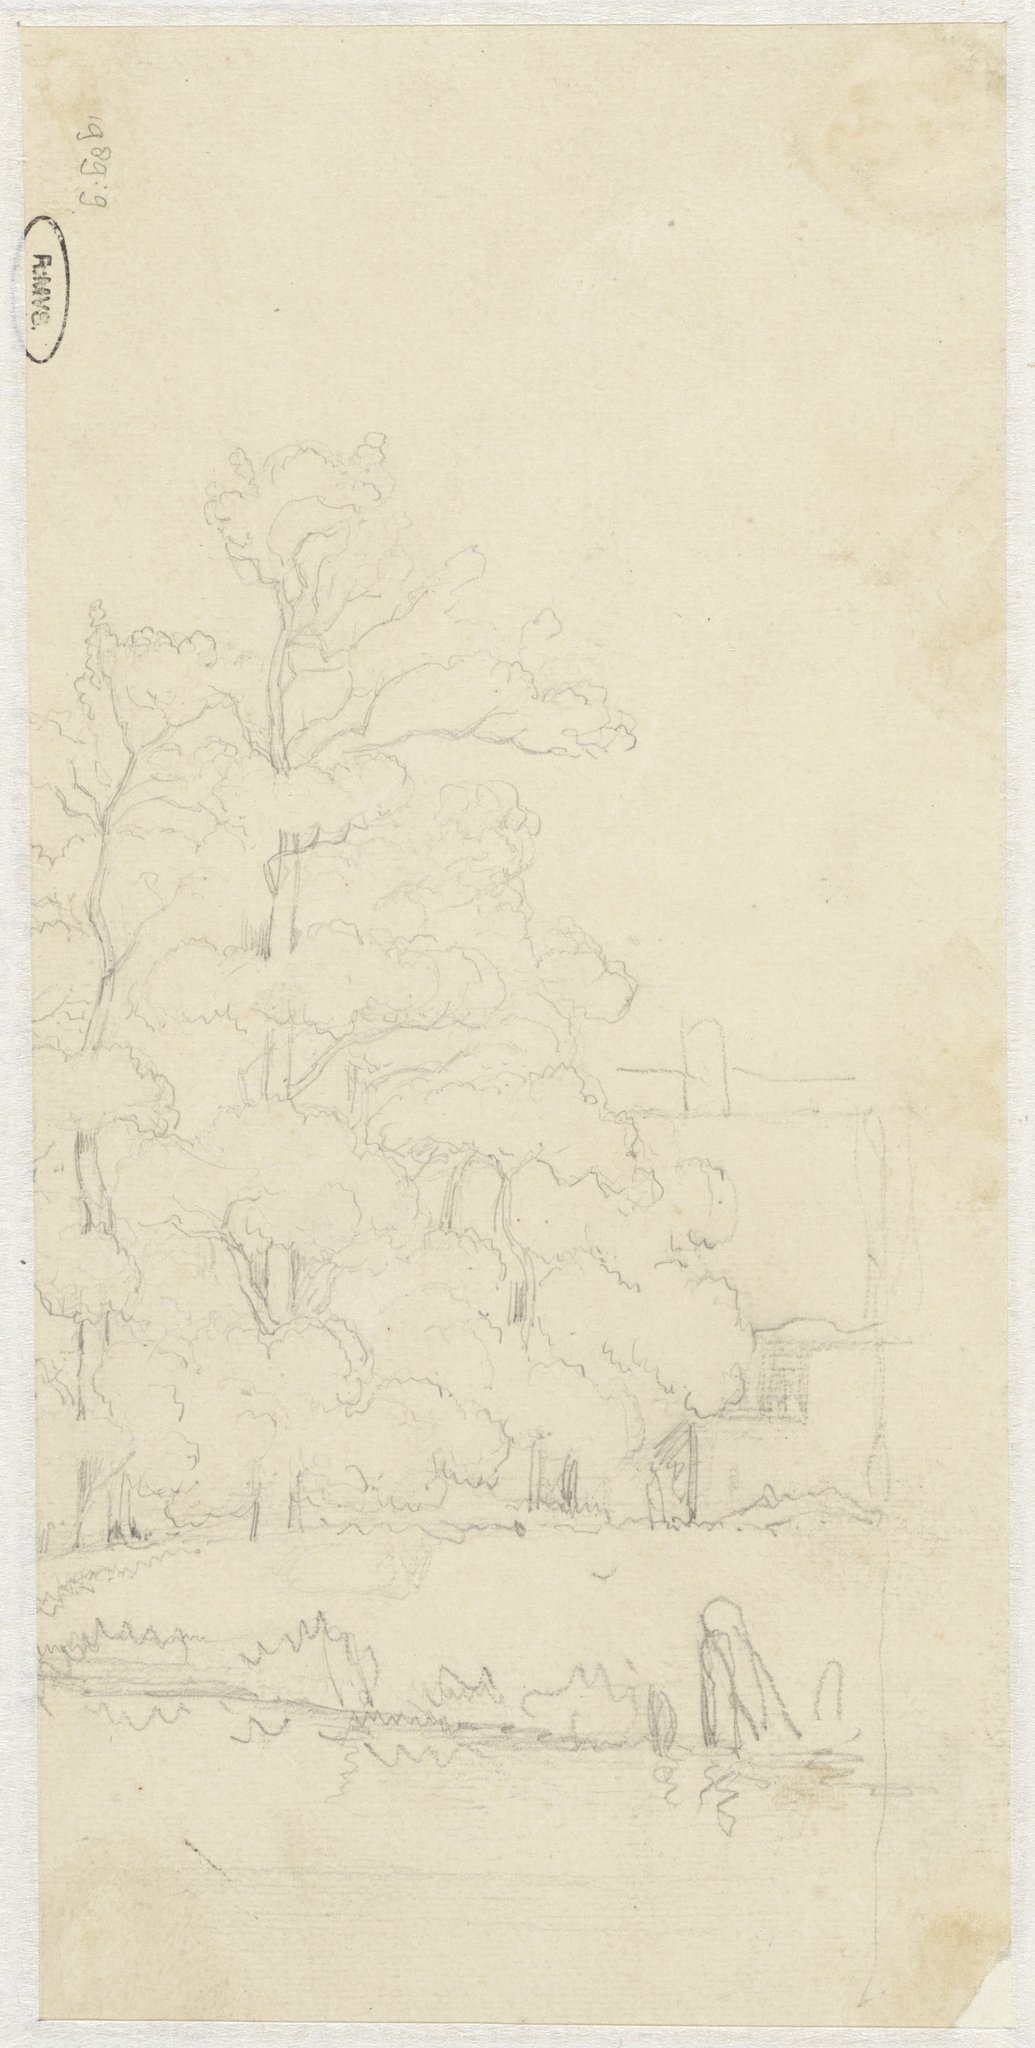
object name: drawing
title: Schets van hoge bomen voor een huis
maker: jacob jan van der maaten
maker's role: draughtsman, print maker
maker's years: 1820-1879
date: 1830-1879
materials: paper, pencil